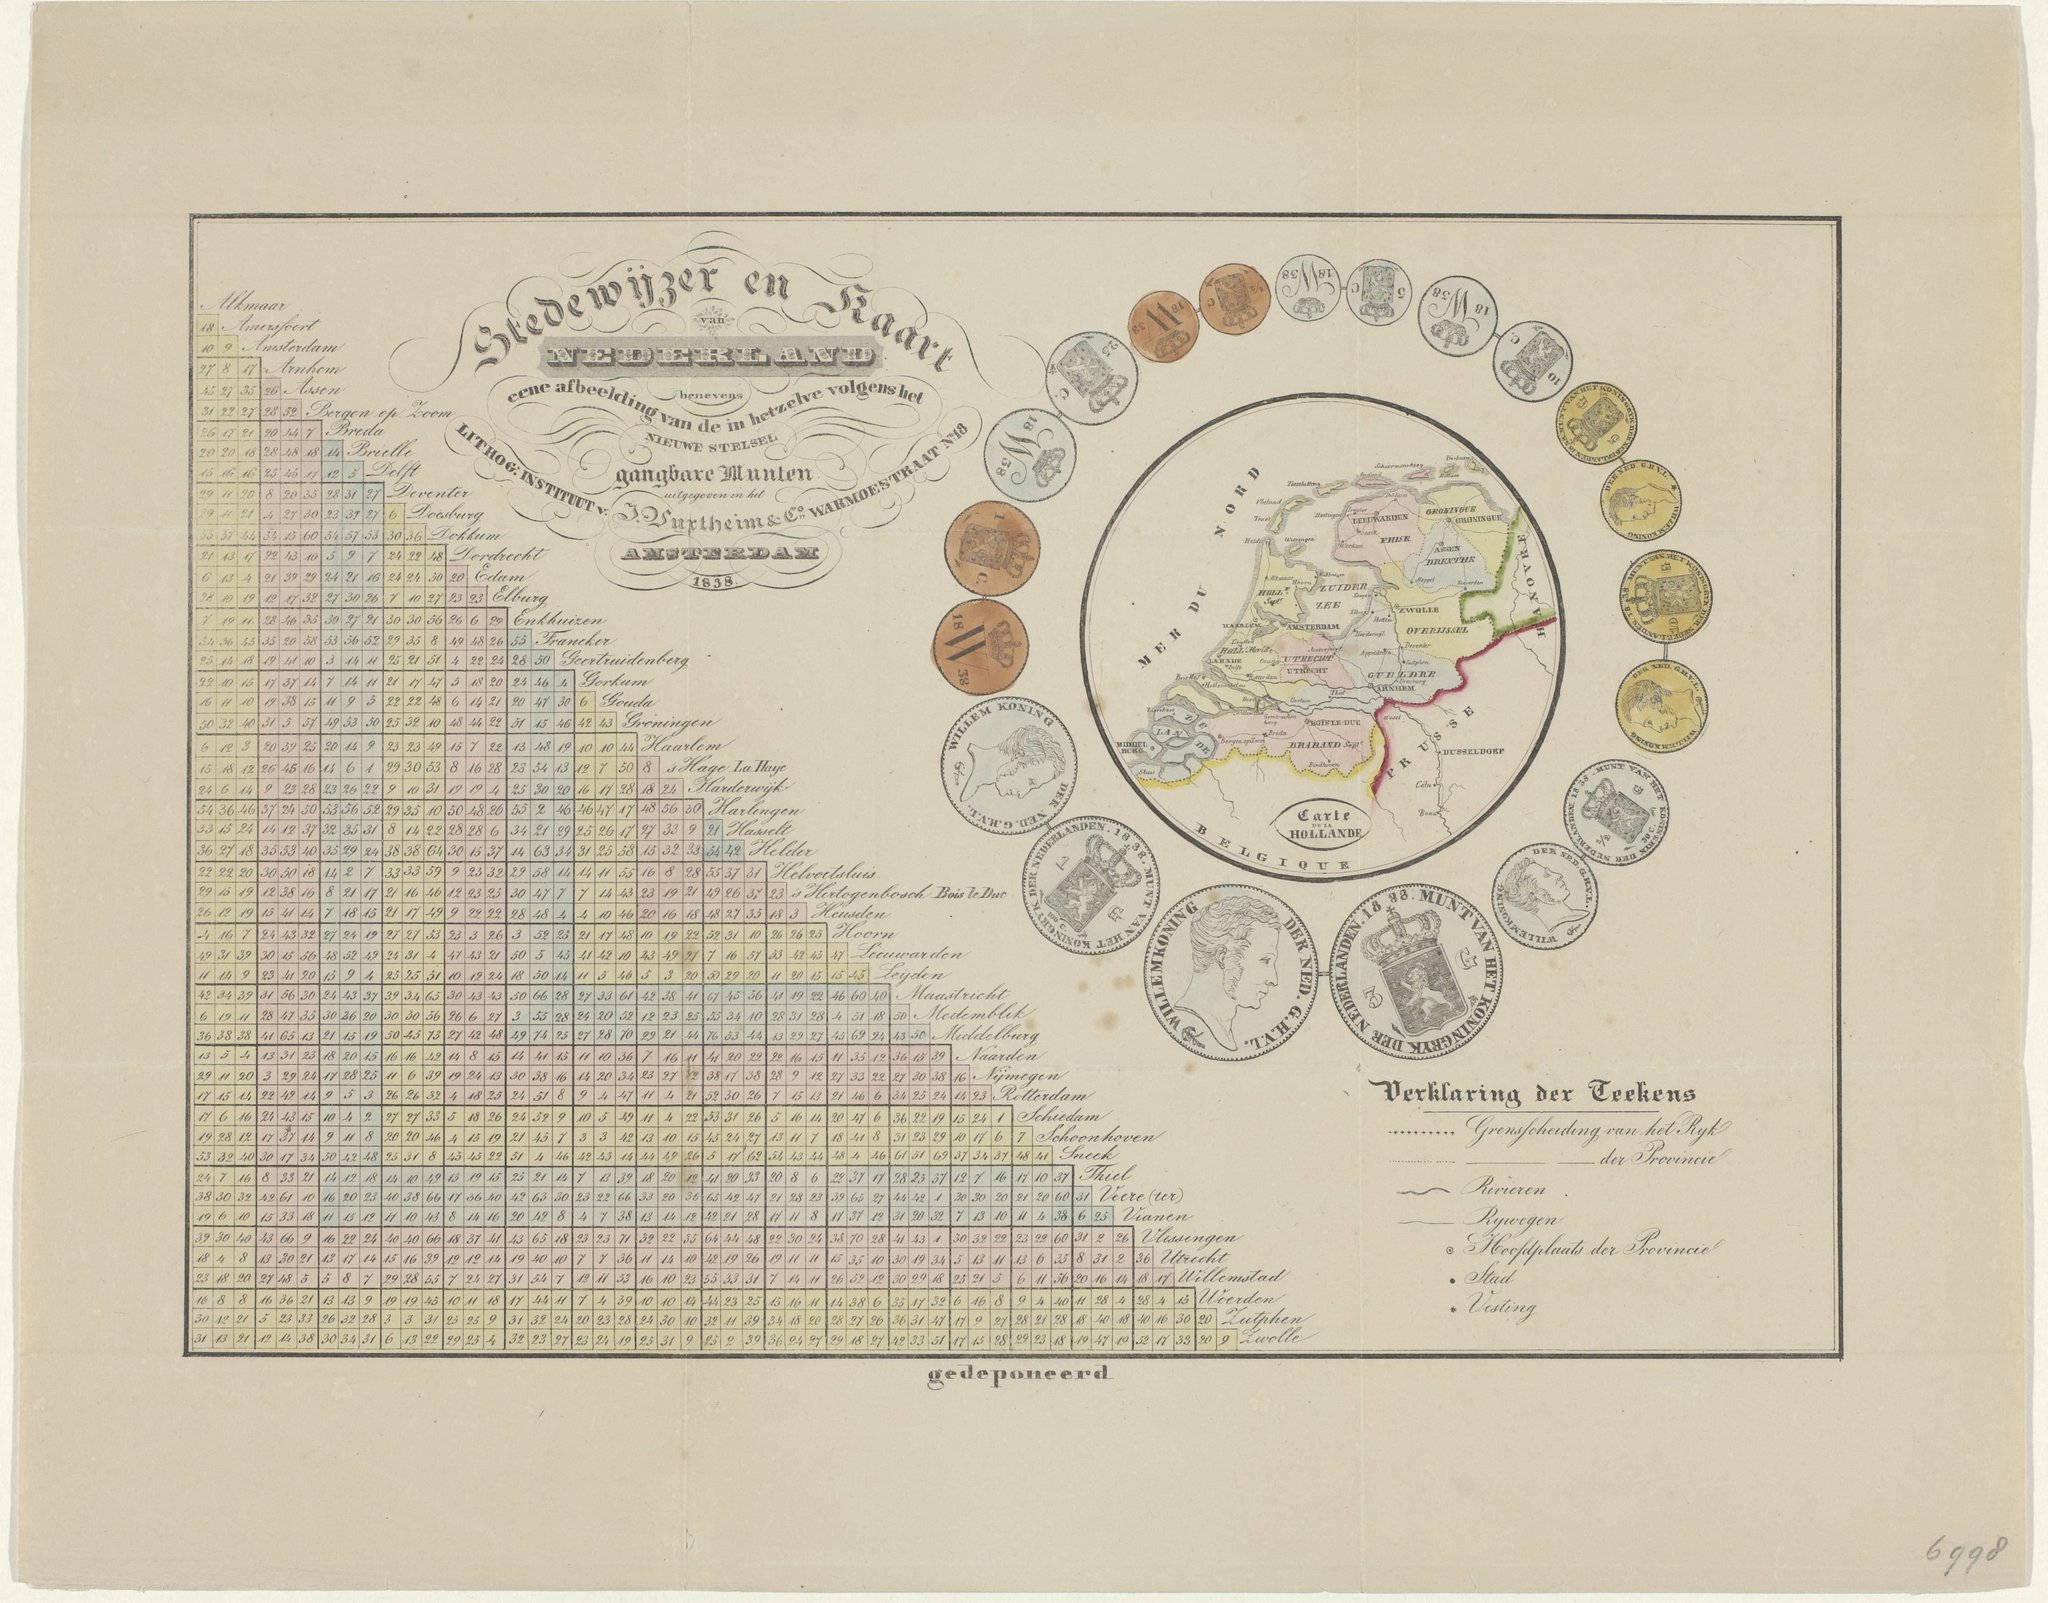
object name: print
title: Stedewijzer en kaart van Nederland benevens eene afbeelding van de in hetzelve volgens het nieuwe stelsel gangbare munten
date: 1838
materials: paper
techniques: hand coloring, lithograph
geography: amsterdam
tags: maps of separate countries or regions, statistic diagram, graph; pictorial chart, etc., coin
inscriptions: : ‘gedeponeerd’, collector's mark: Lugt 2228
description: Tabel van de afstanden tussen de belangrijkste Nederlandse steden plus een overzicht van de volgens het nieuwe stelsel van 1838 gangbare munten. De munten met voor- en keerzijde afgebeeld in een cirkel om een kleine kaart van Nederland.